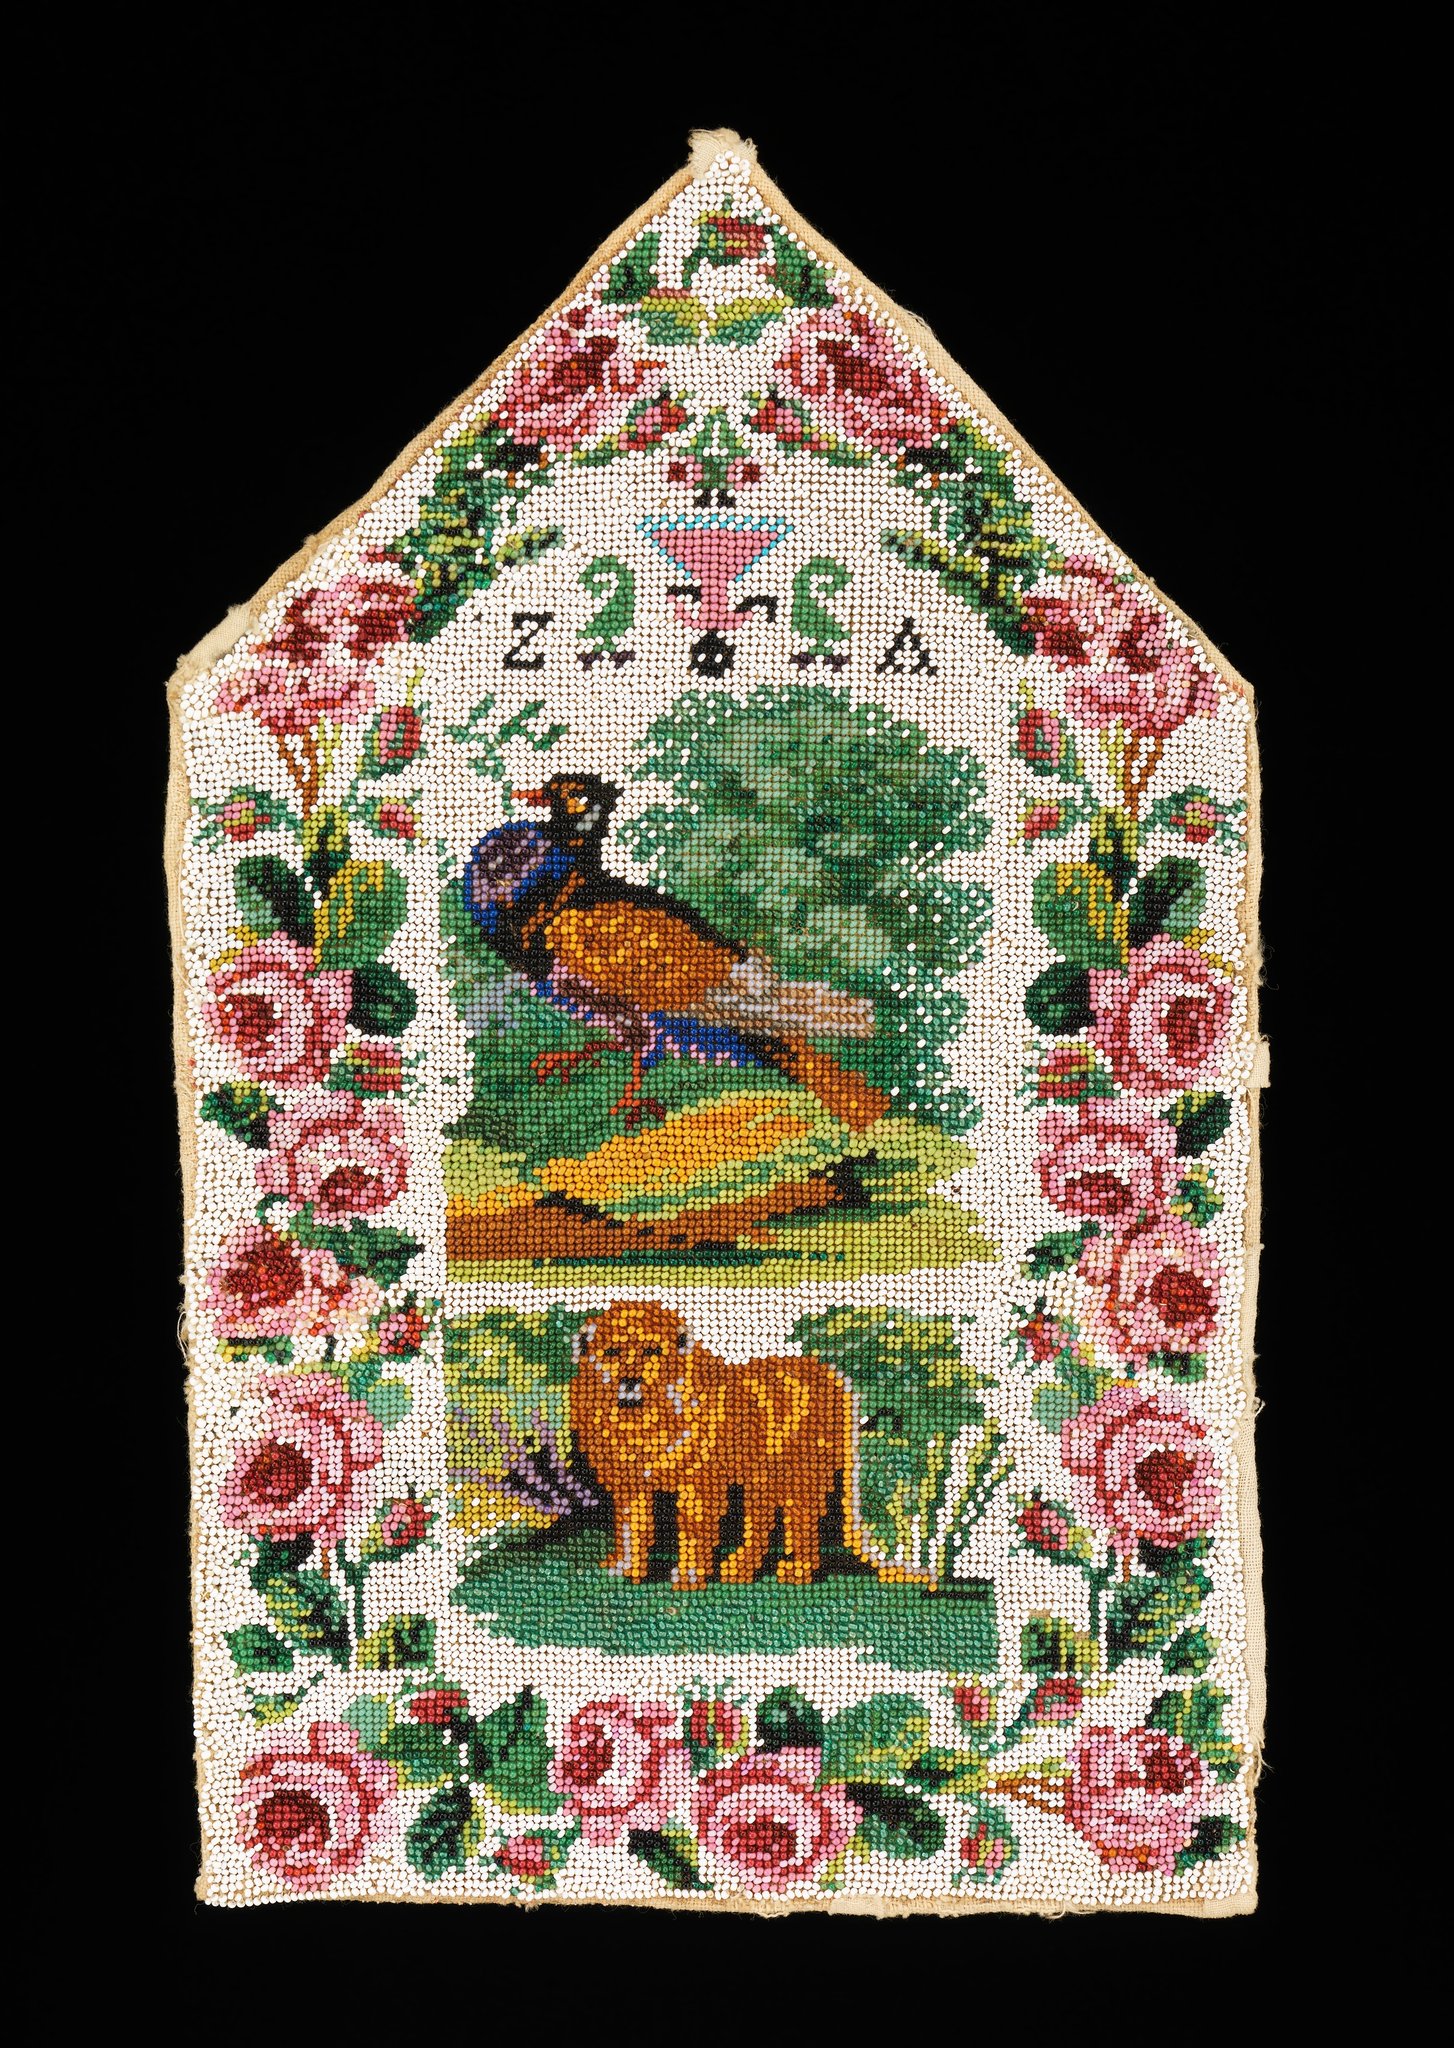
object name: bag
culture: mexican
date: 1840-1860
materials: glass, linen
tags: birds,lions